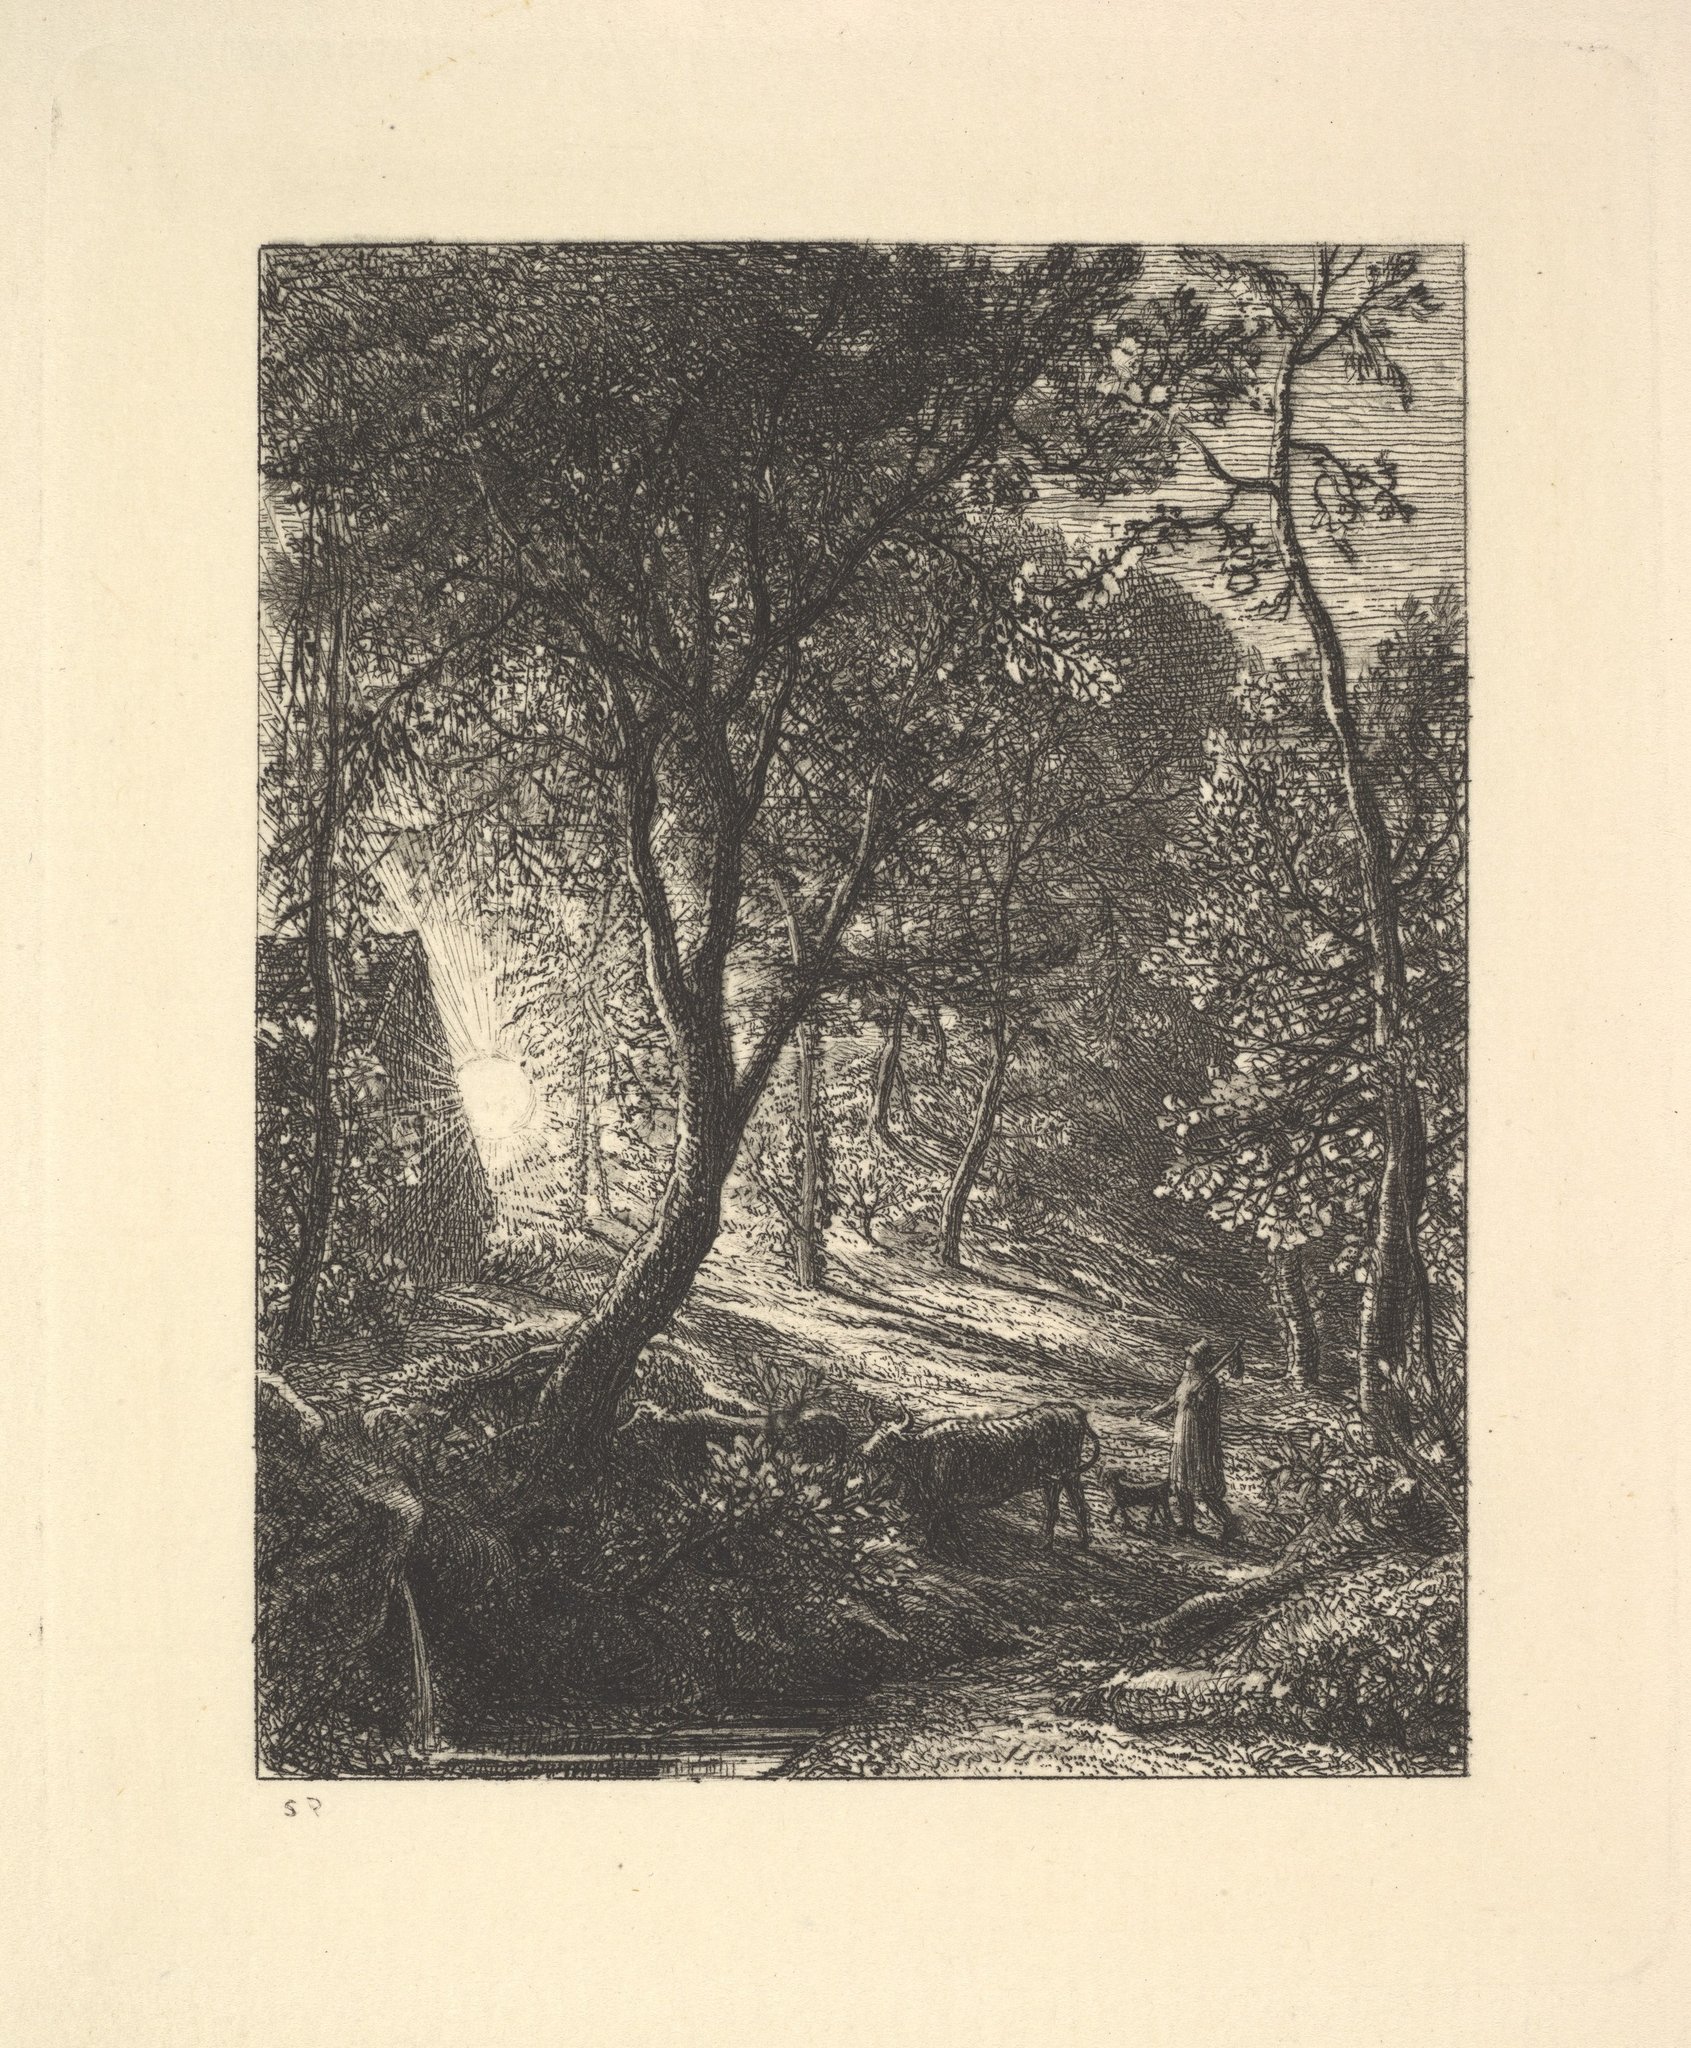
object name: print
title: The Herdsman's Cottage, or Sunset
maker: samuel palmer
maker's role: artist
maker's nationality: british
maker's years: 1805-1881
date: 1880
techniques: etching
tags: forests,evening